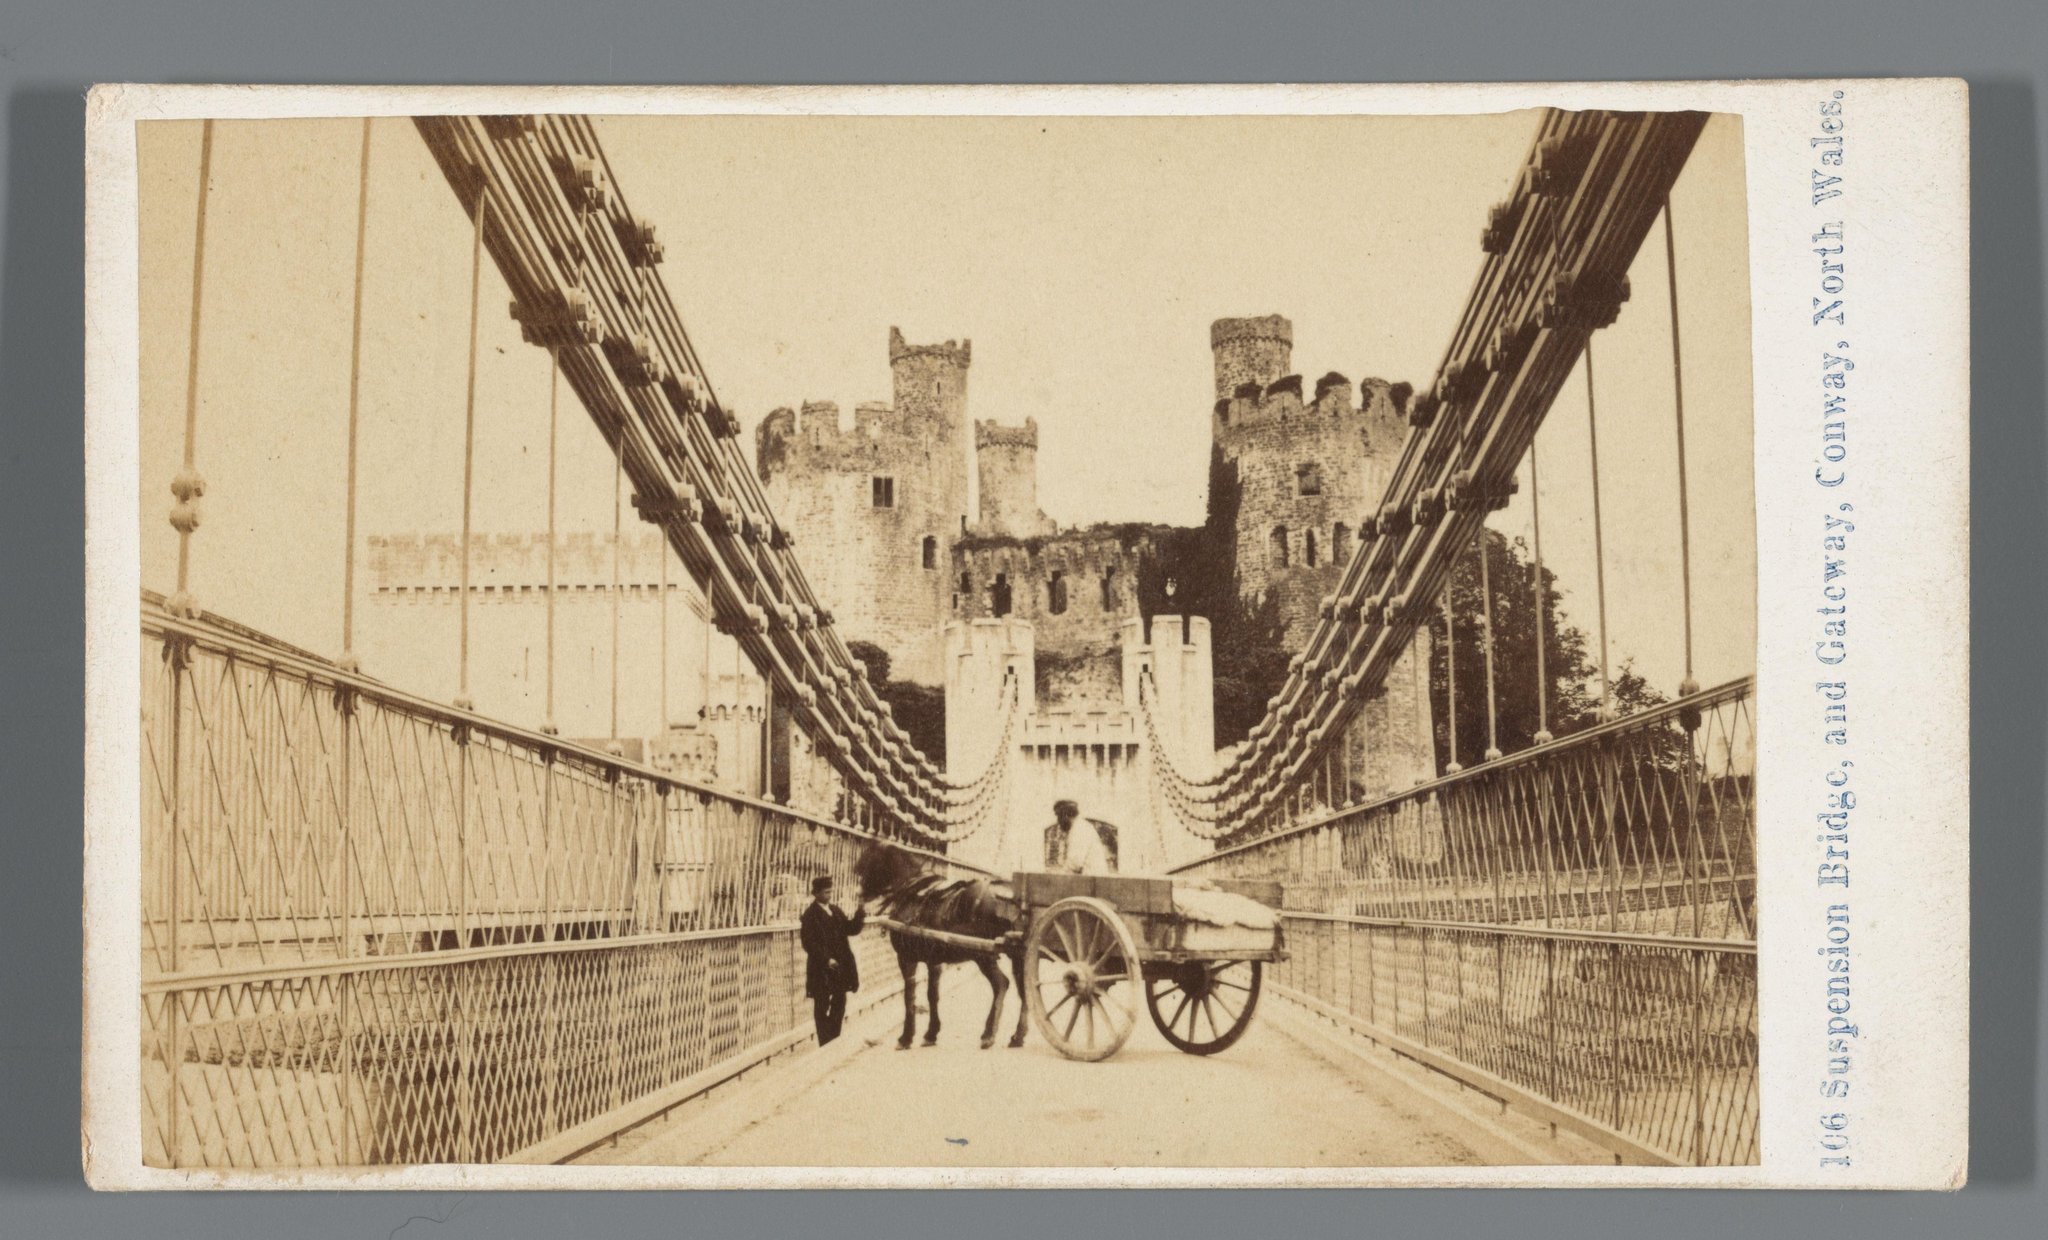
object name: photograph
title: Suspension Bridge, and Gateway, Conway, North Wales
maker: abraham findlow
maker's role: fotograaf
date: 1860-1865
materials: cardboard, paper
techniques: albumen print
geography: wales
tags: castle, suspension bridge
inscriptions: inscription: ‘166 Suspension Bridge, and Gateway, Conway, North Wales.’, inscription: ‘A. Findlow/ Photographer/ Smith St./ Warwick./ Established 1855./ Negatives kept./ Copies always to be had.’